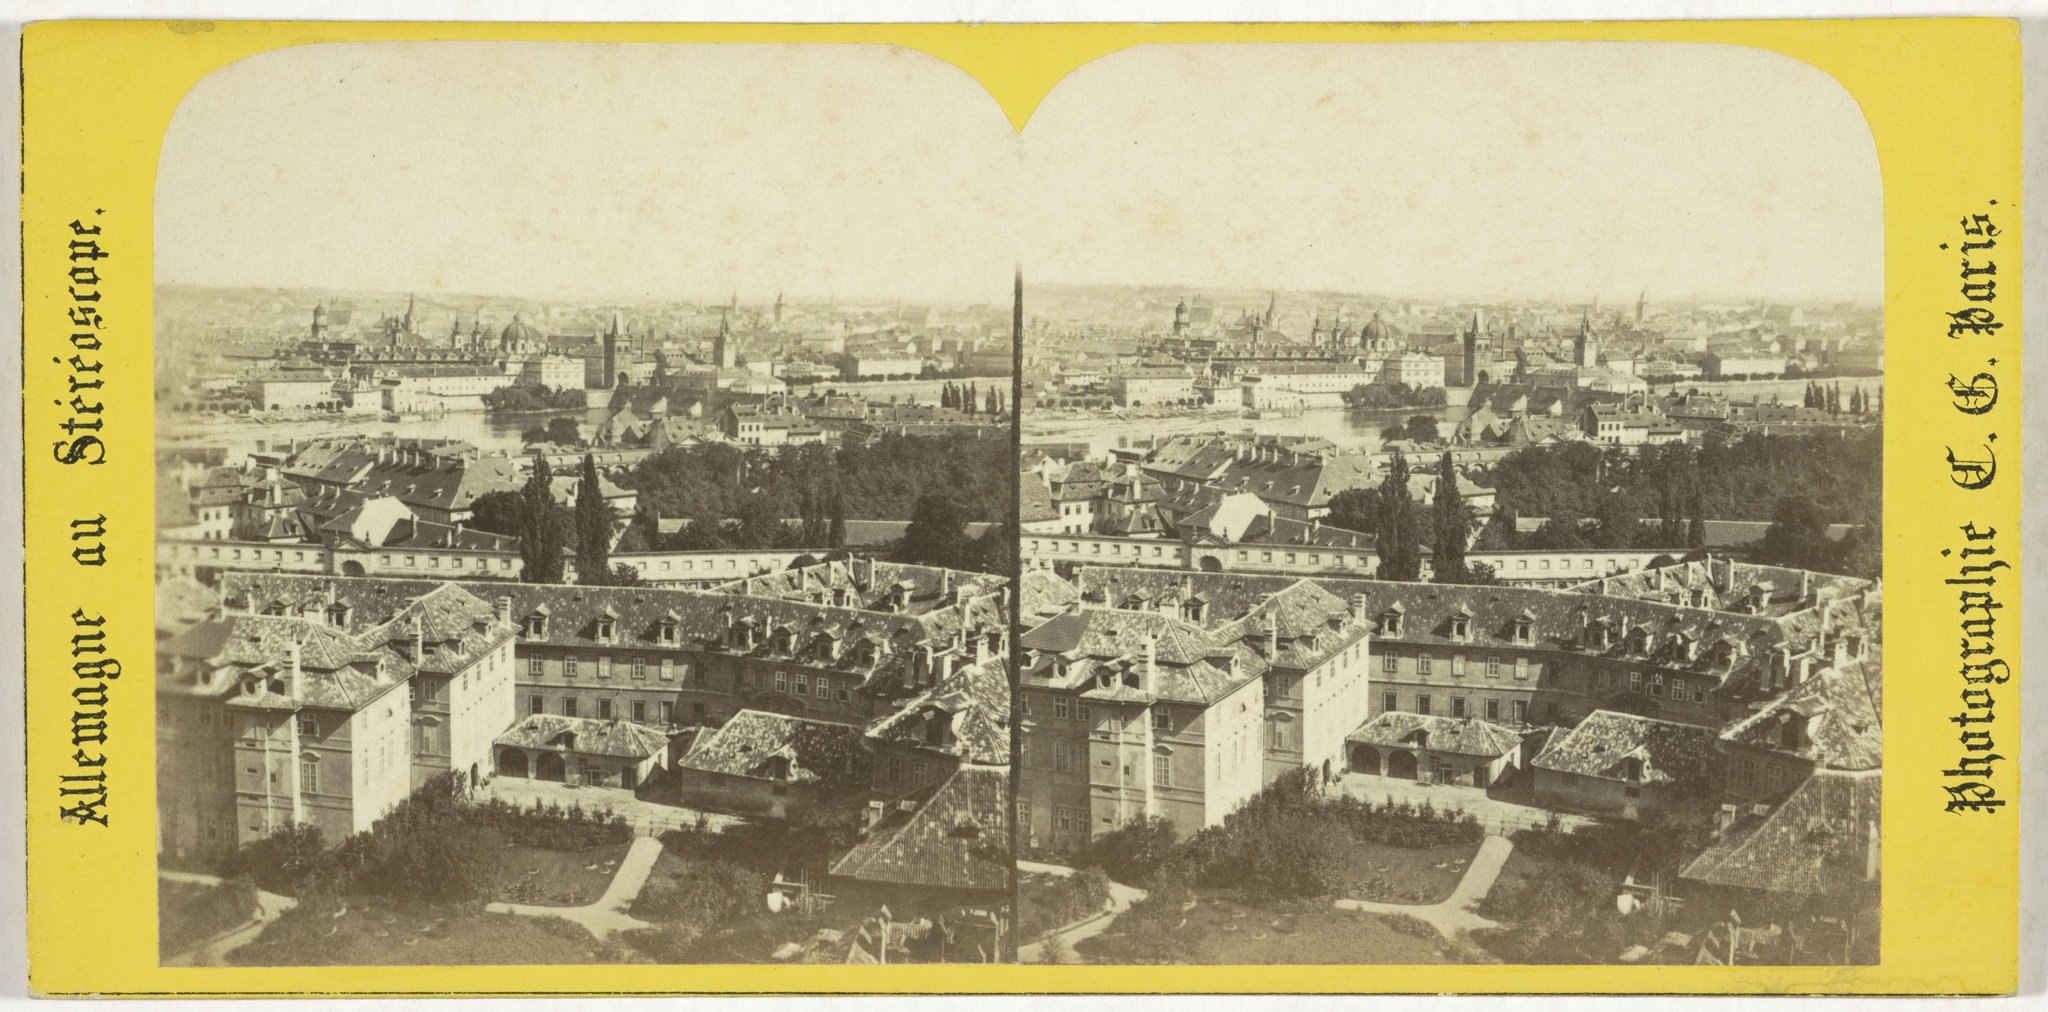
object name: stereograph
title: Gezicht op Praag vanaf de Praagse burcht, Hradčany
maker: charles gérard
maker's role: fotograaf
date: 1868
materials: cardboard, paper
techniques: albumen print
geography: hradčany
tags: city-view in general; 'veduta', prague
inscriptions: number: ‘195’, inscription: ‘195 [?]’